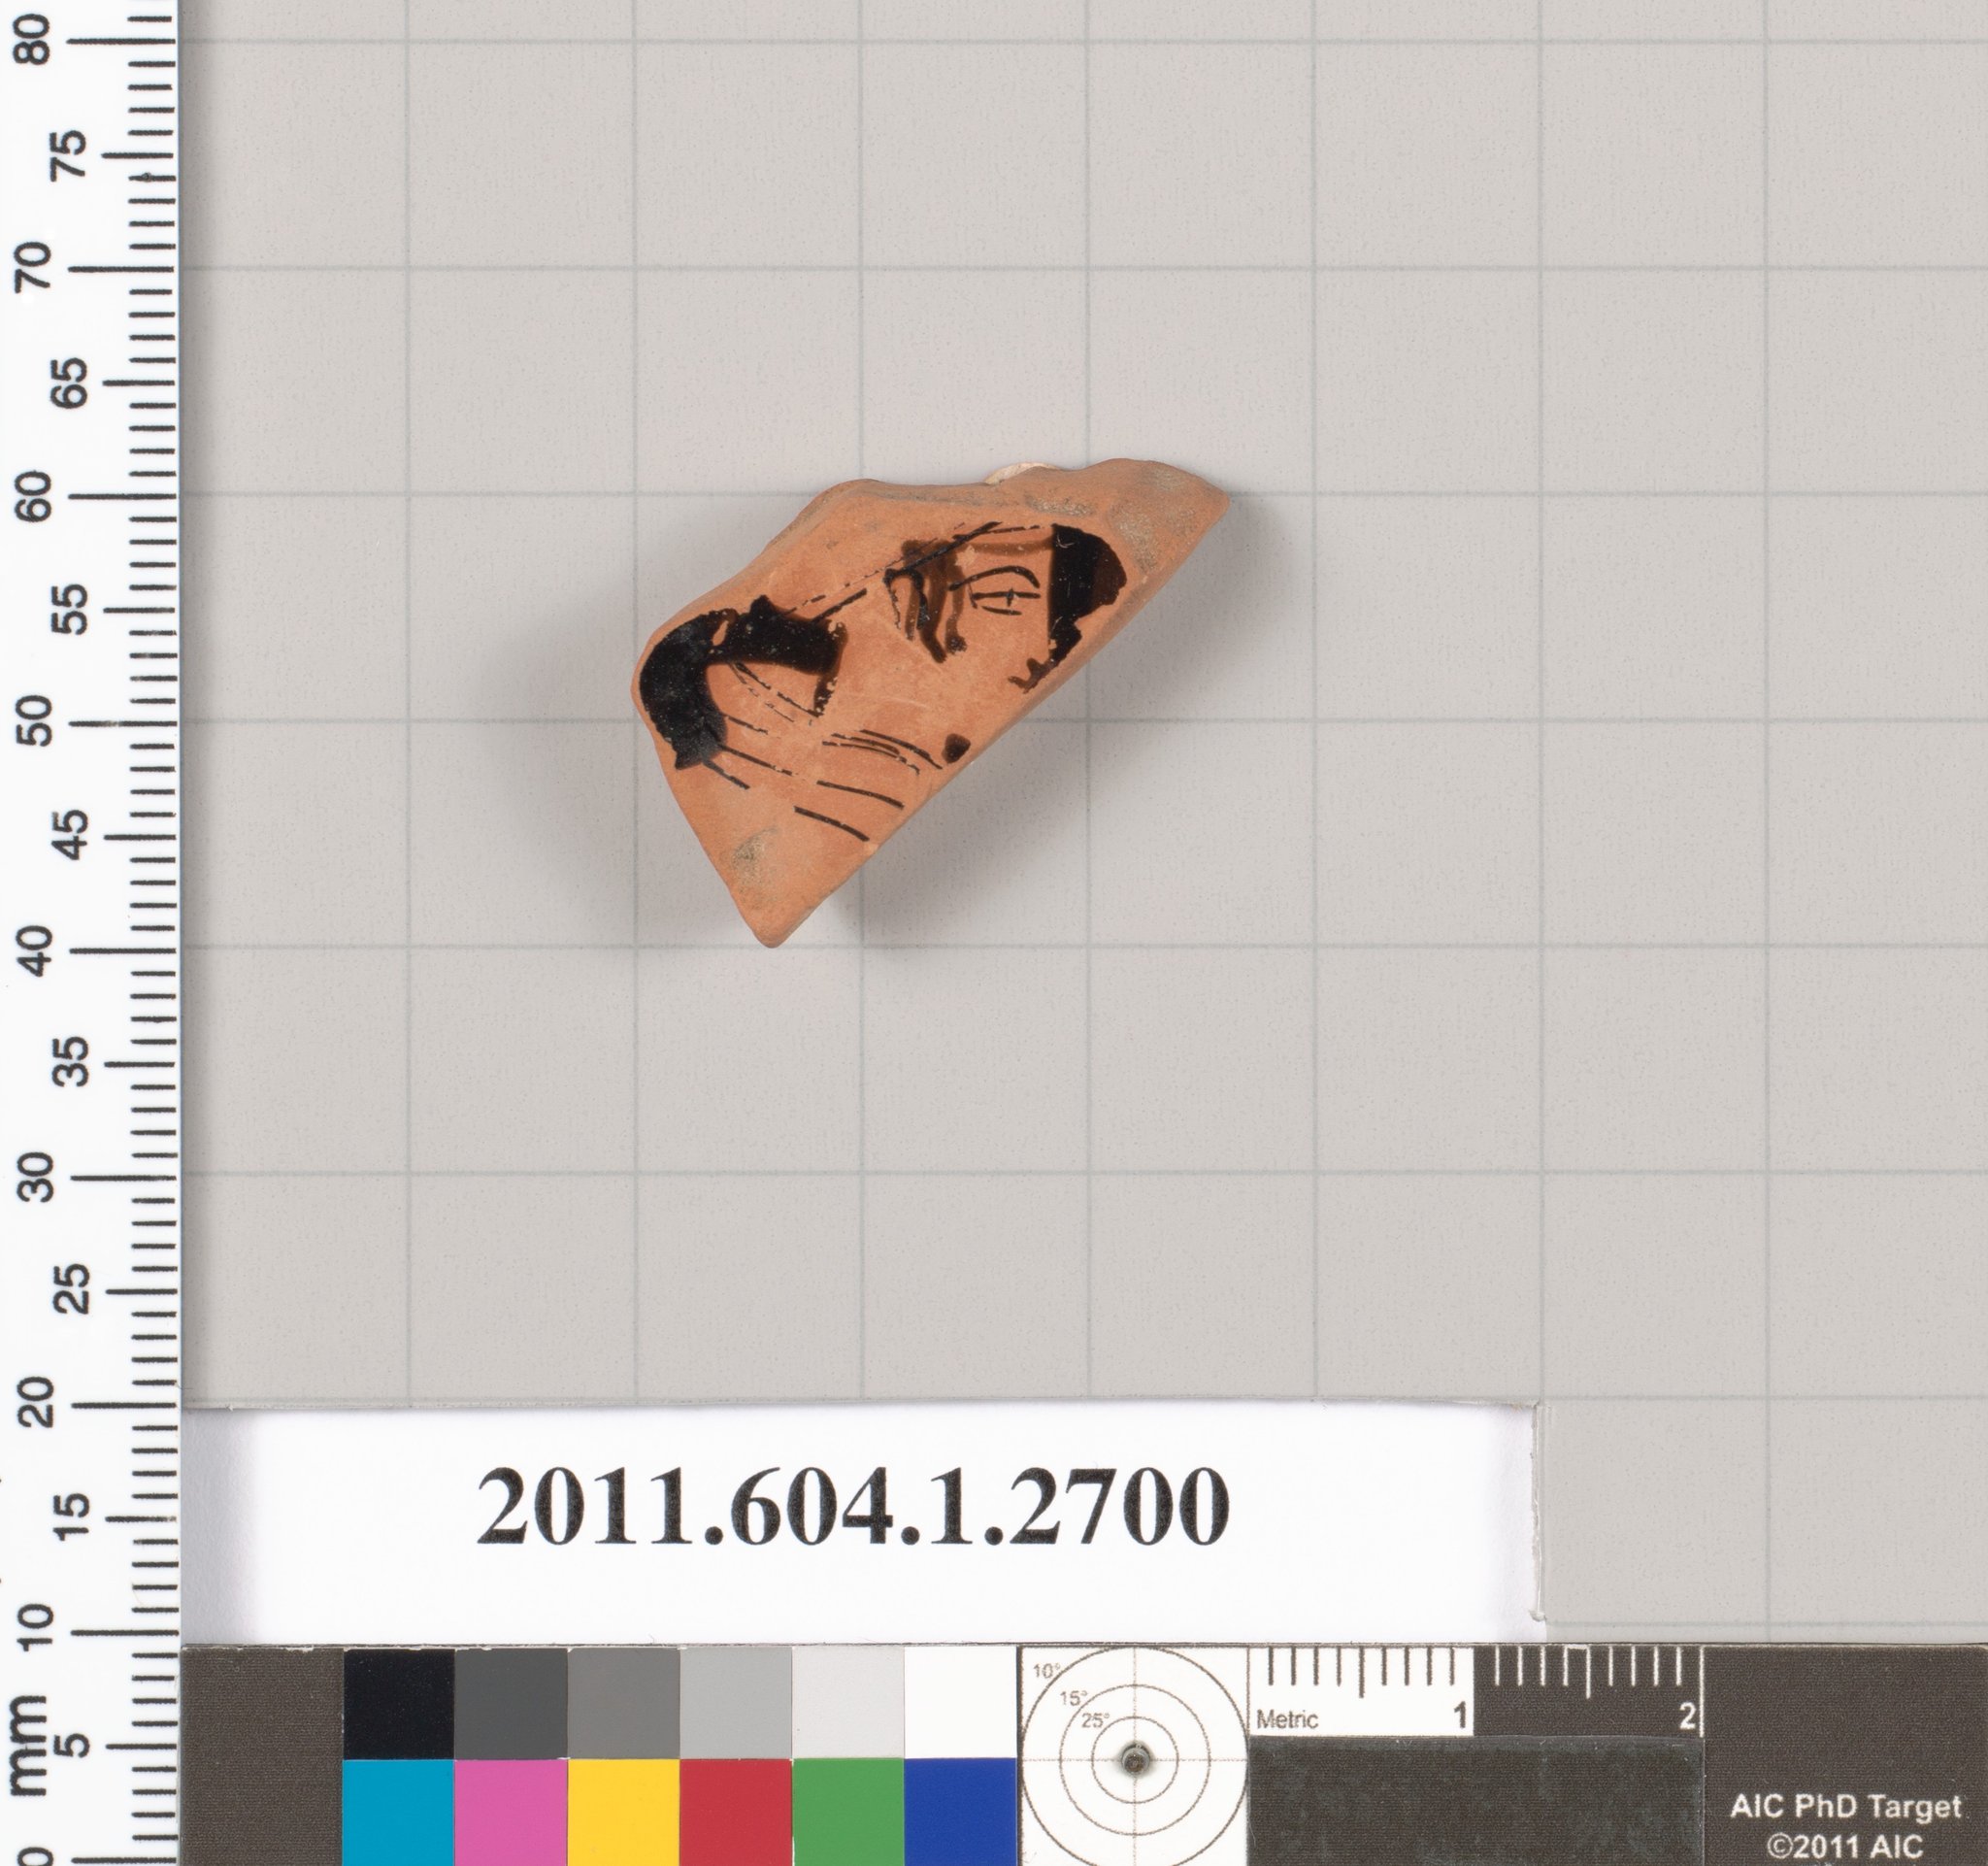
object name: kylix fragment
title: Terracotta fragment of a kylix (drinking cup)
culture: greek, attic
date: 470-460 BCE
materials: terracotta